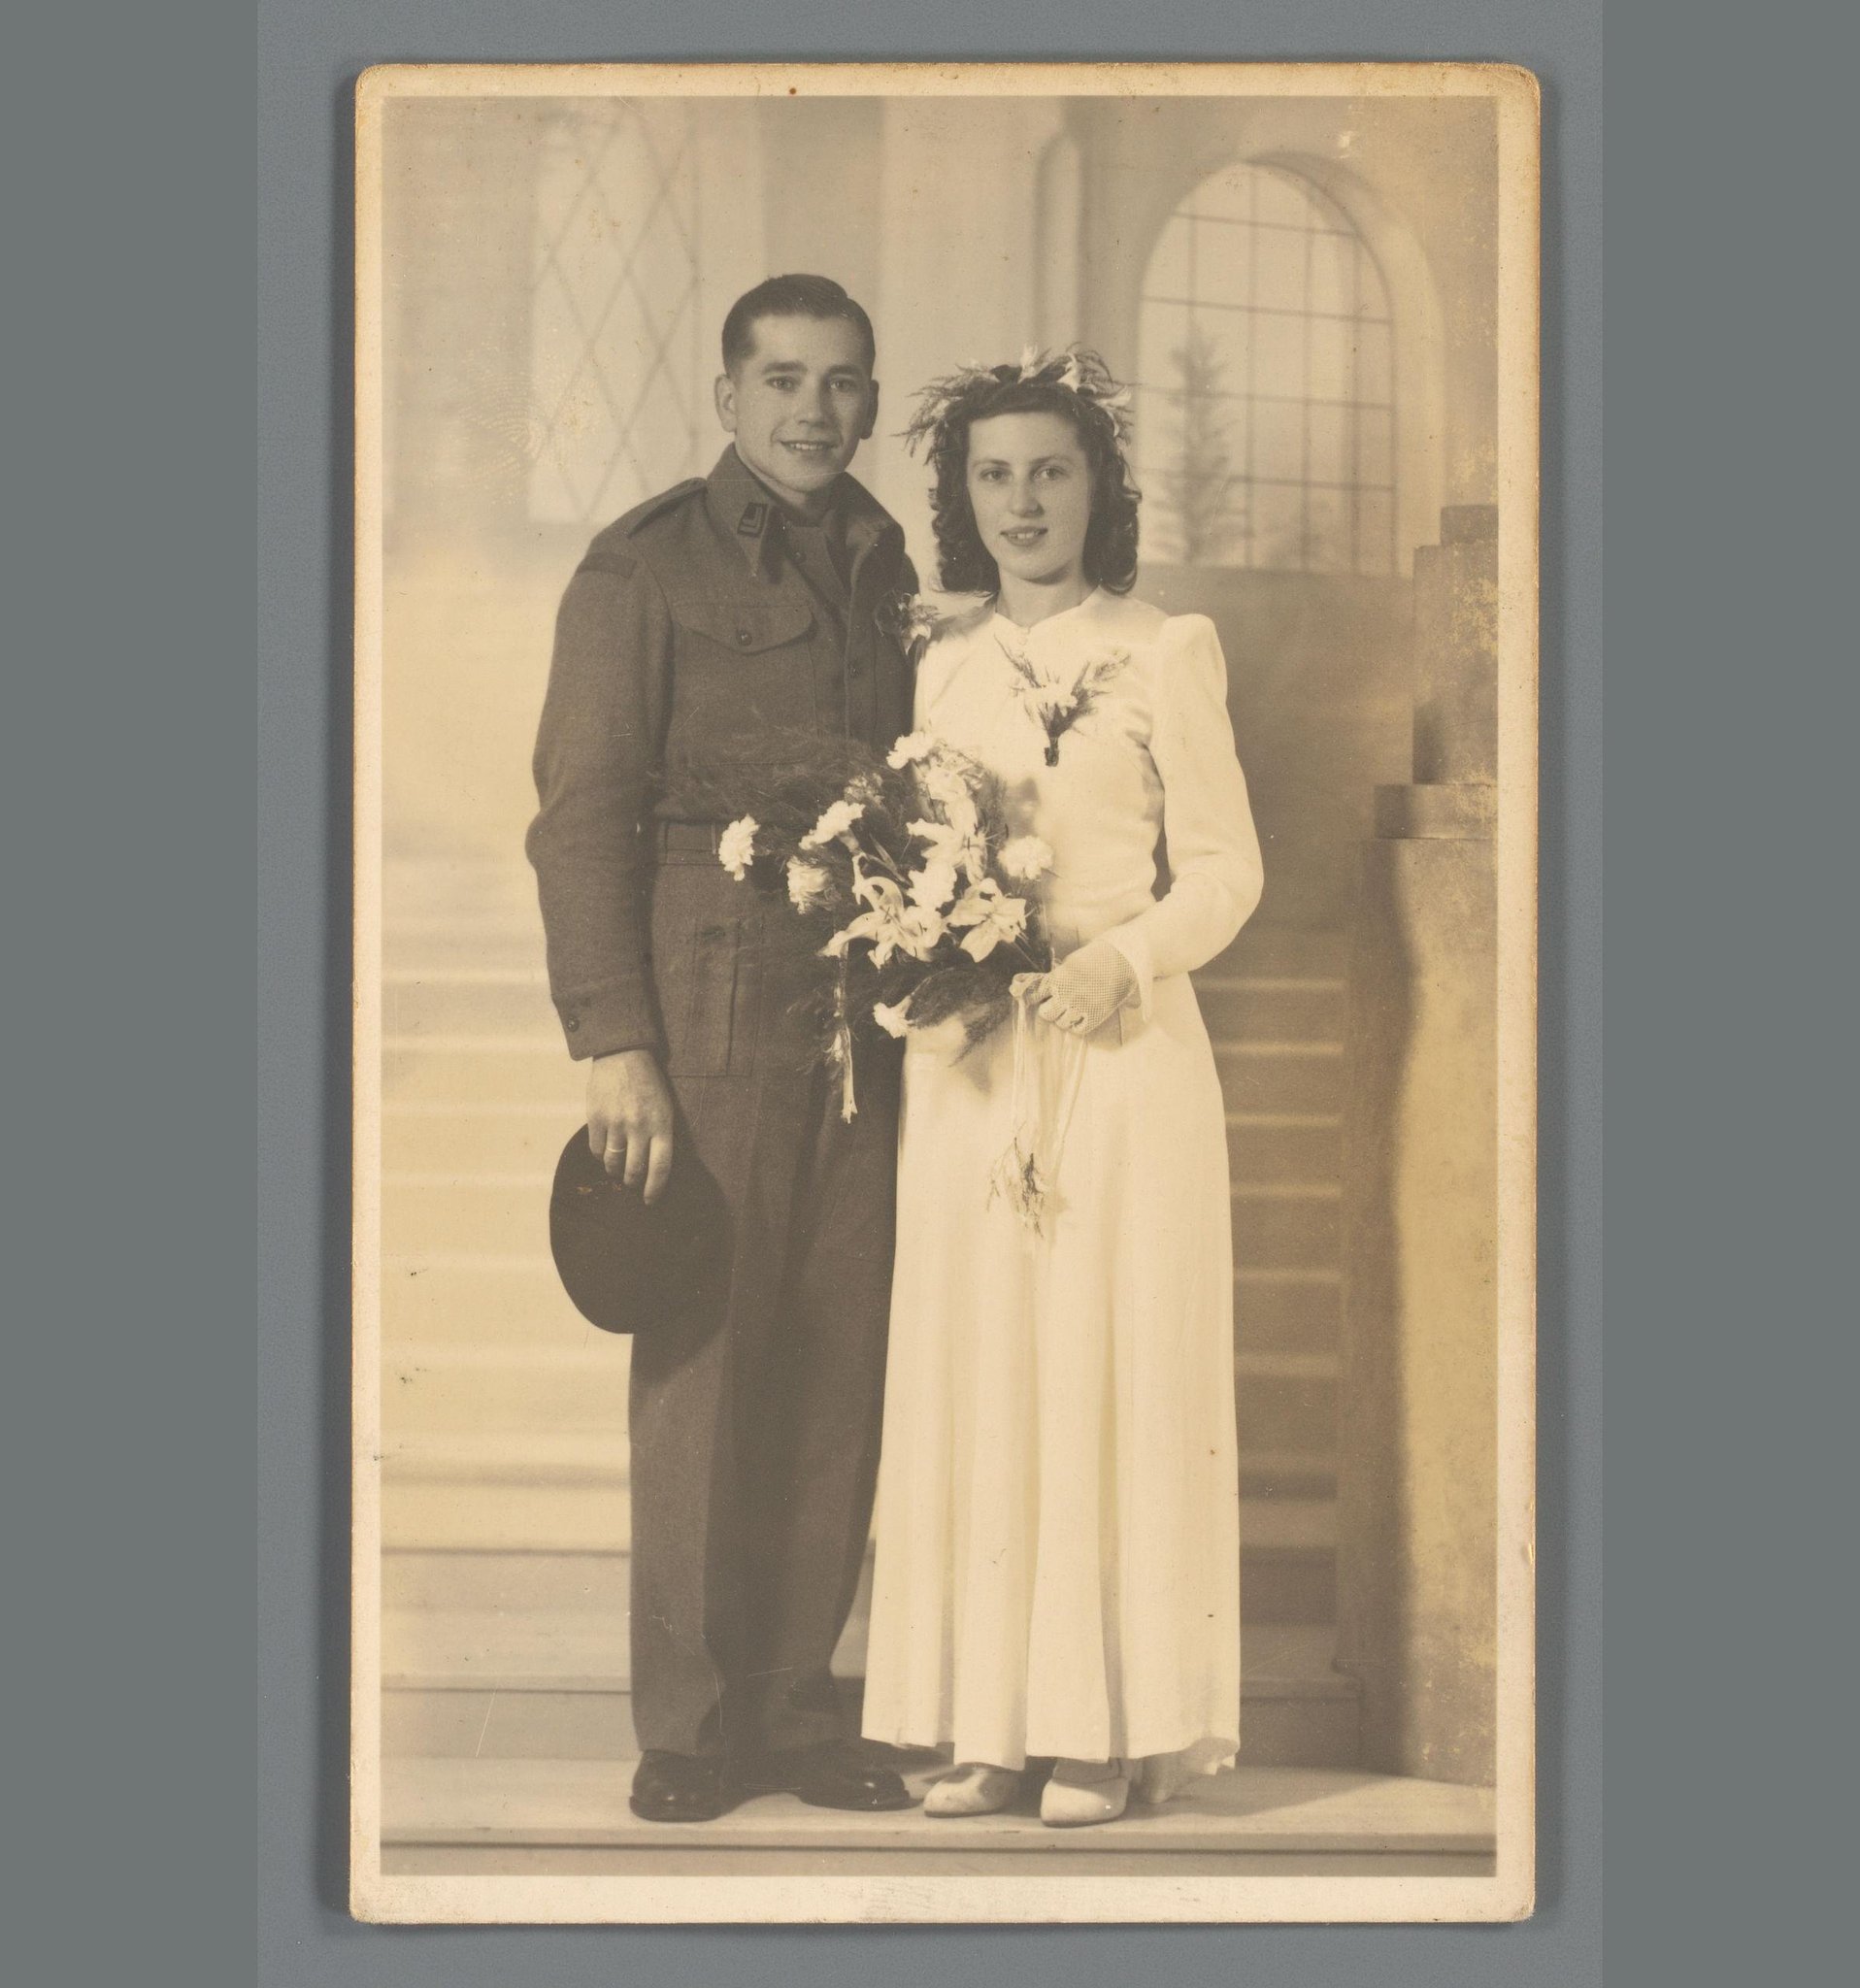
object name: photograph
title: Huwelijksportret van Sierk Noordhoff en Tjenkje Bakker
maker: Anonymous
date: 1930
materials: paper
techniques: gelatin silver print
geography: leeuwarden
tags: historical persons, bride and groom in wedding-dress, (military) uniforms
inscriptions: inscription: ‘Sierk Noordhoff/ oom Benken[?]’